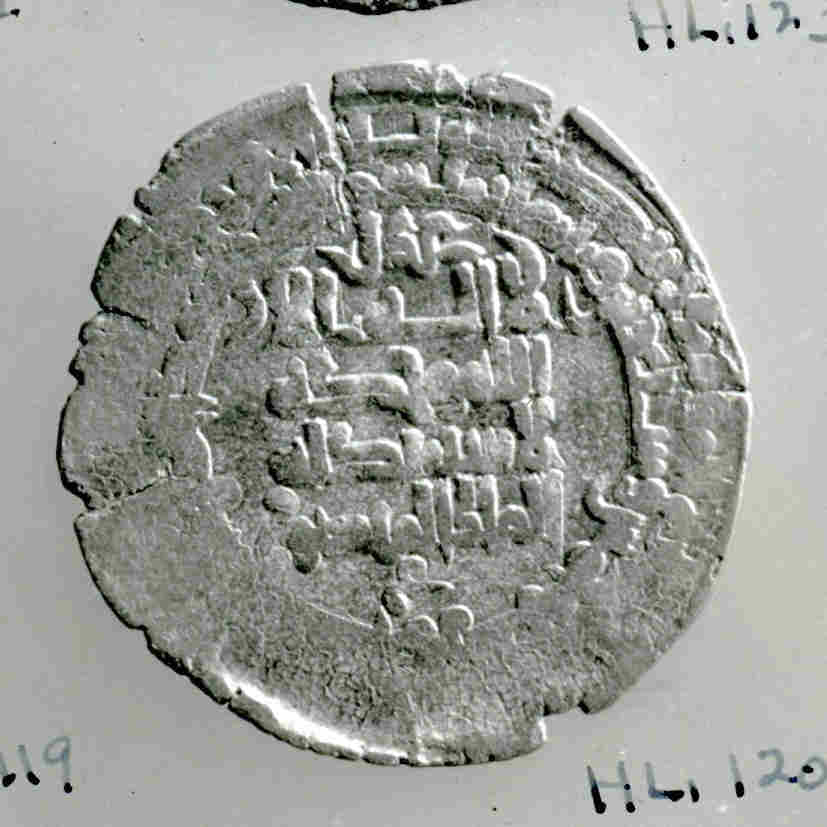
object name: coin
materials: silver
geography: al-shash